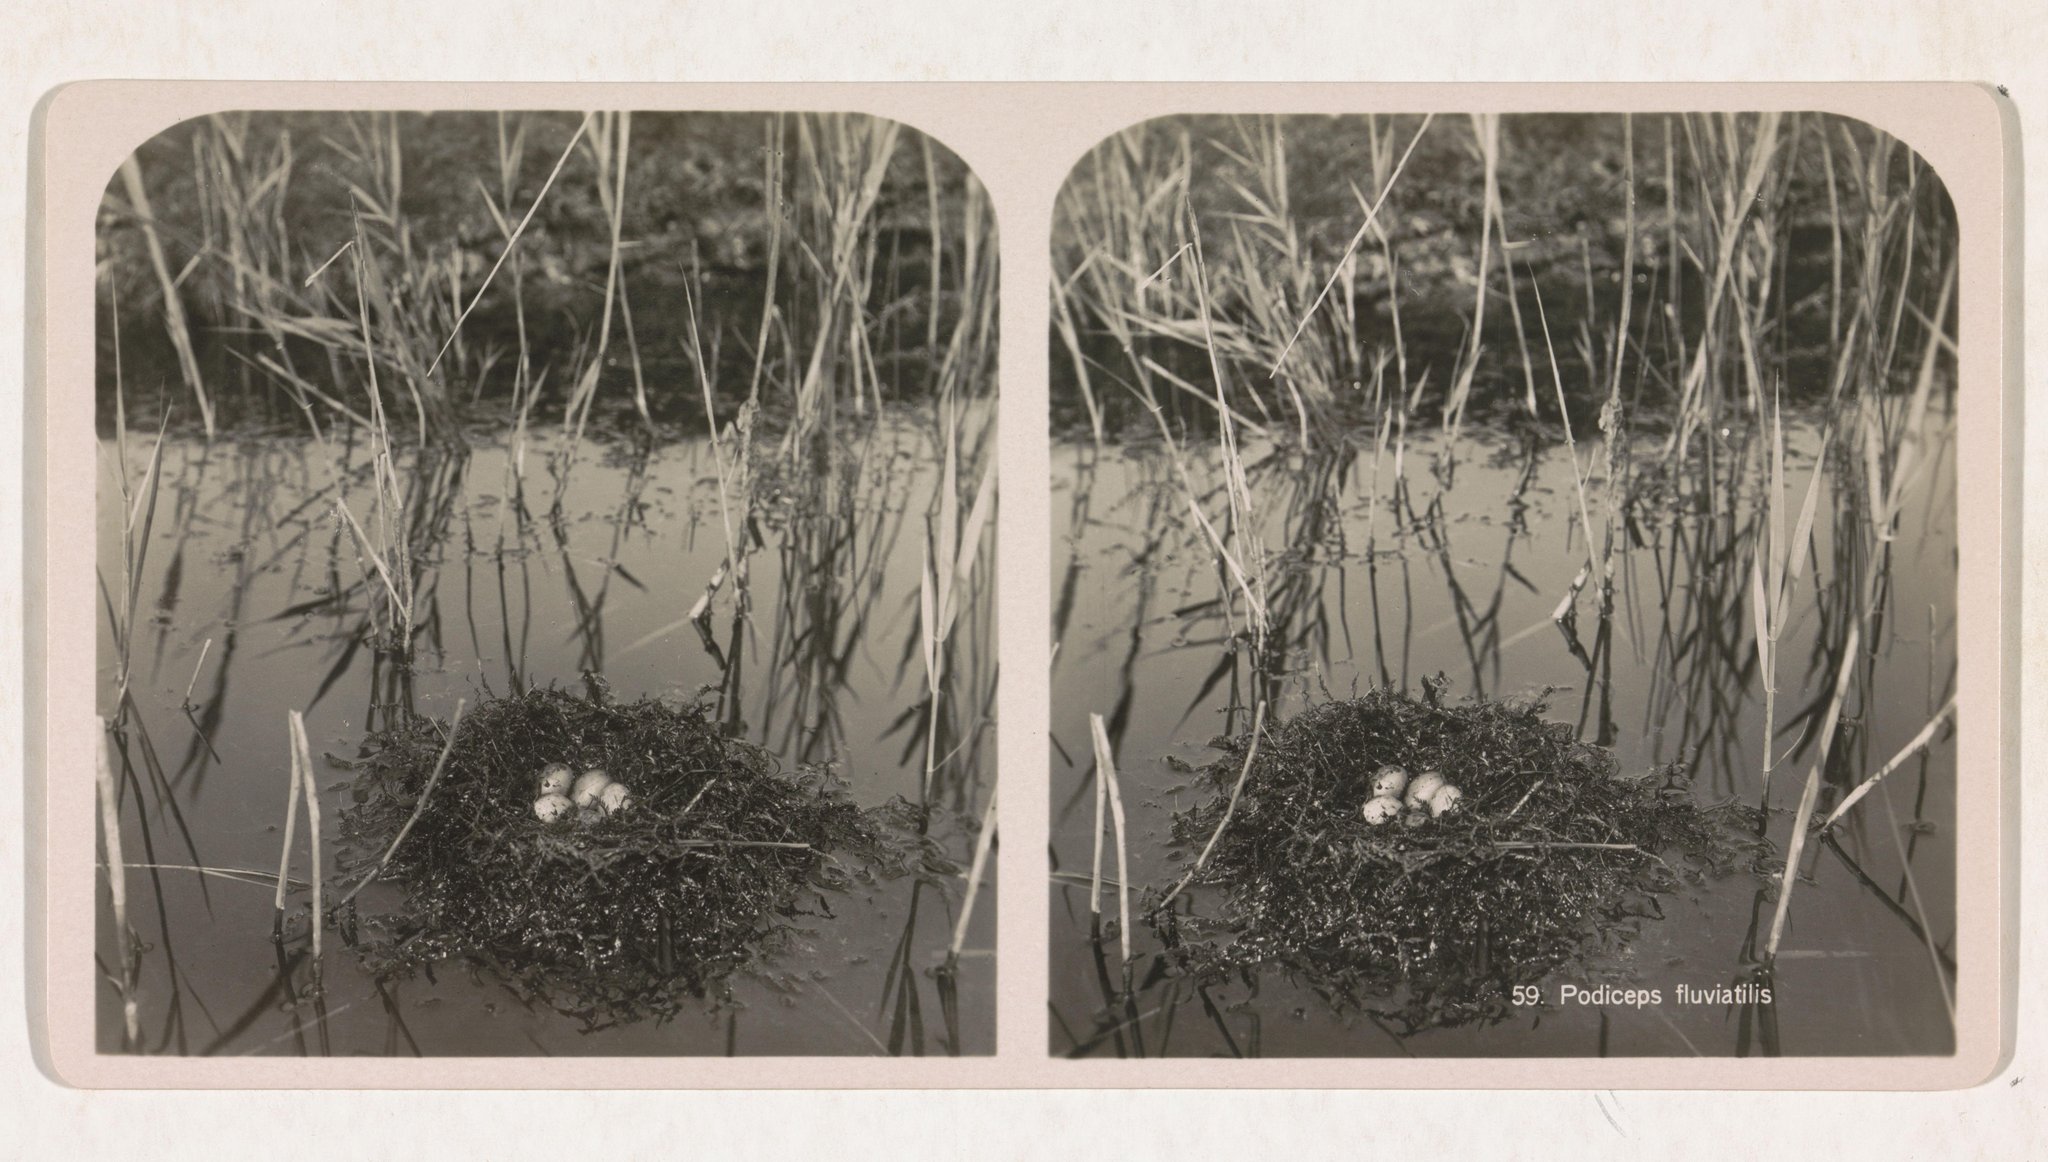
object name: photograph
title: Onze vogels in 't wild. / Moerasvogels / Lepelaar, Reiger, Roerdomp, Dodaars, Zwarte Stern.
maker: adolphe burdet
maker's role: fotograaf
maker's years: 1860-1940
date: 1870-1940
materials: photographic support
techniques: gelatin silver print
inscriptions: label: ‘Fuut’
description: De foto is afkomstig uit een serie van 12 stereofoto's met moerasvogels die bewaard worden in het originele mapje. Bij dit mapje zit ook een blaadje met gedrukte tekst over de vogels.